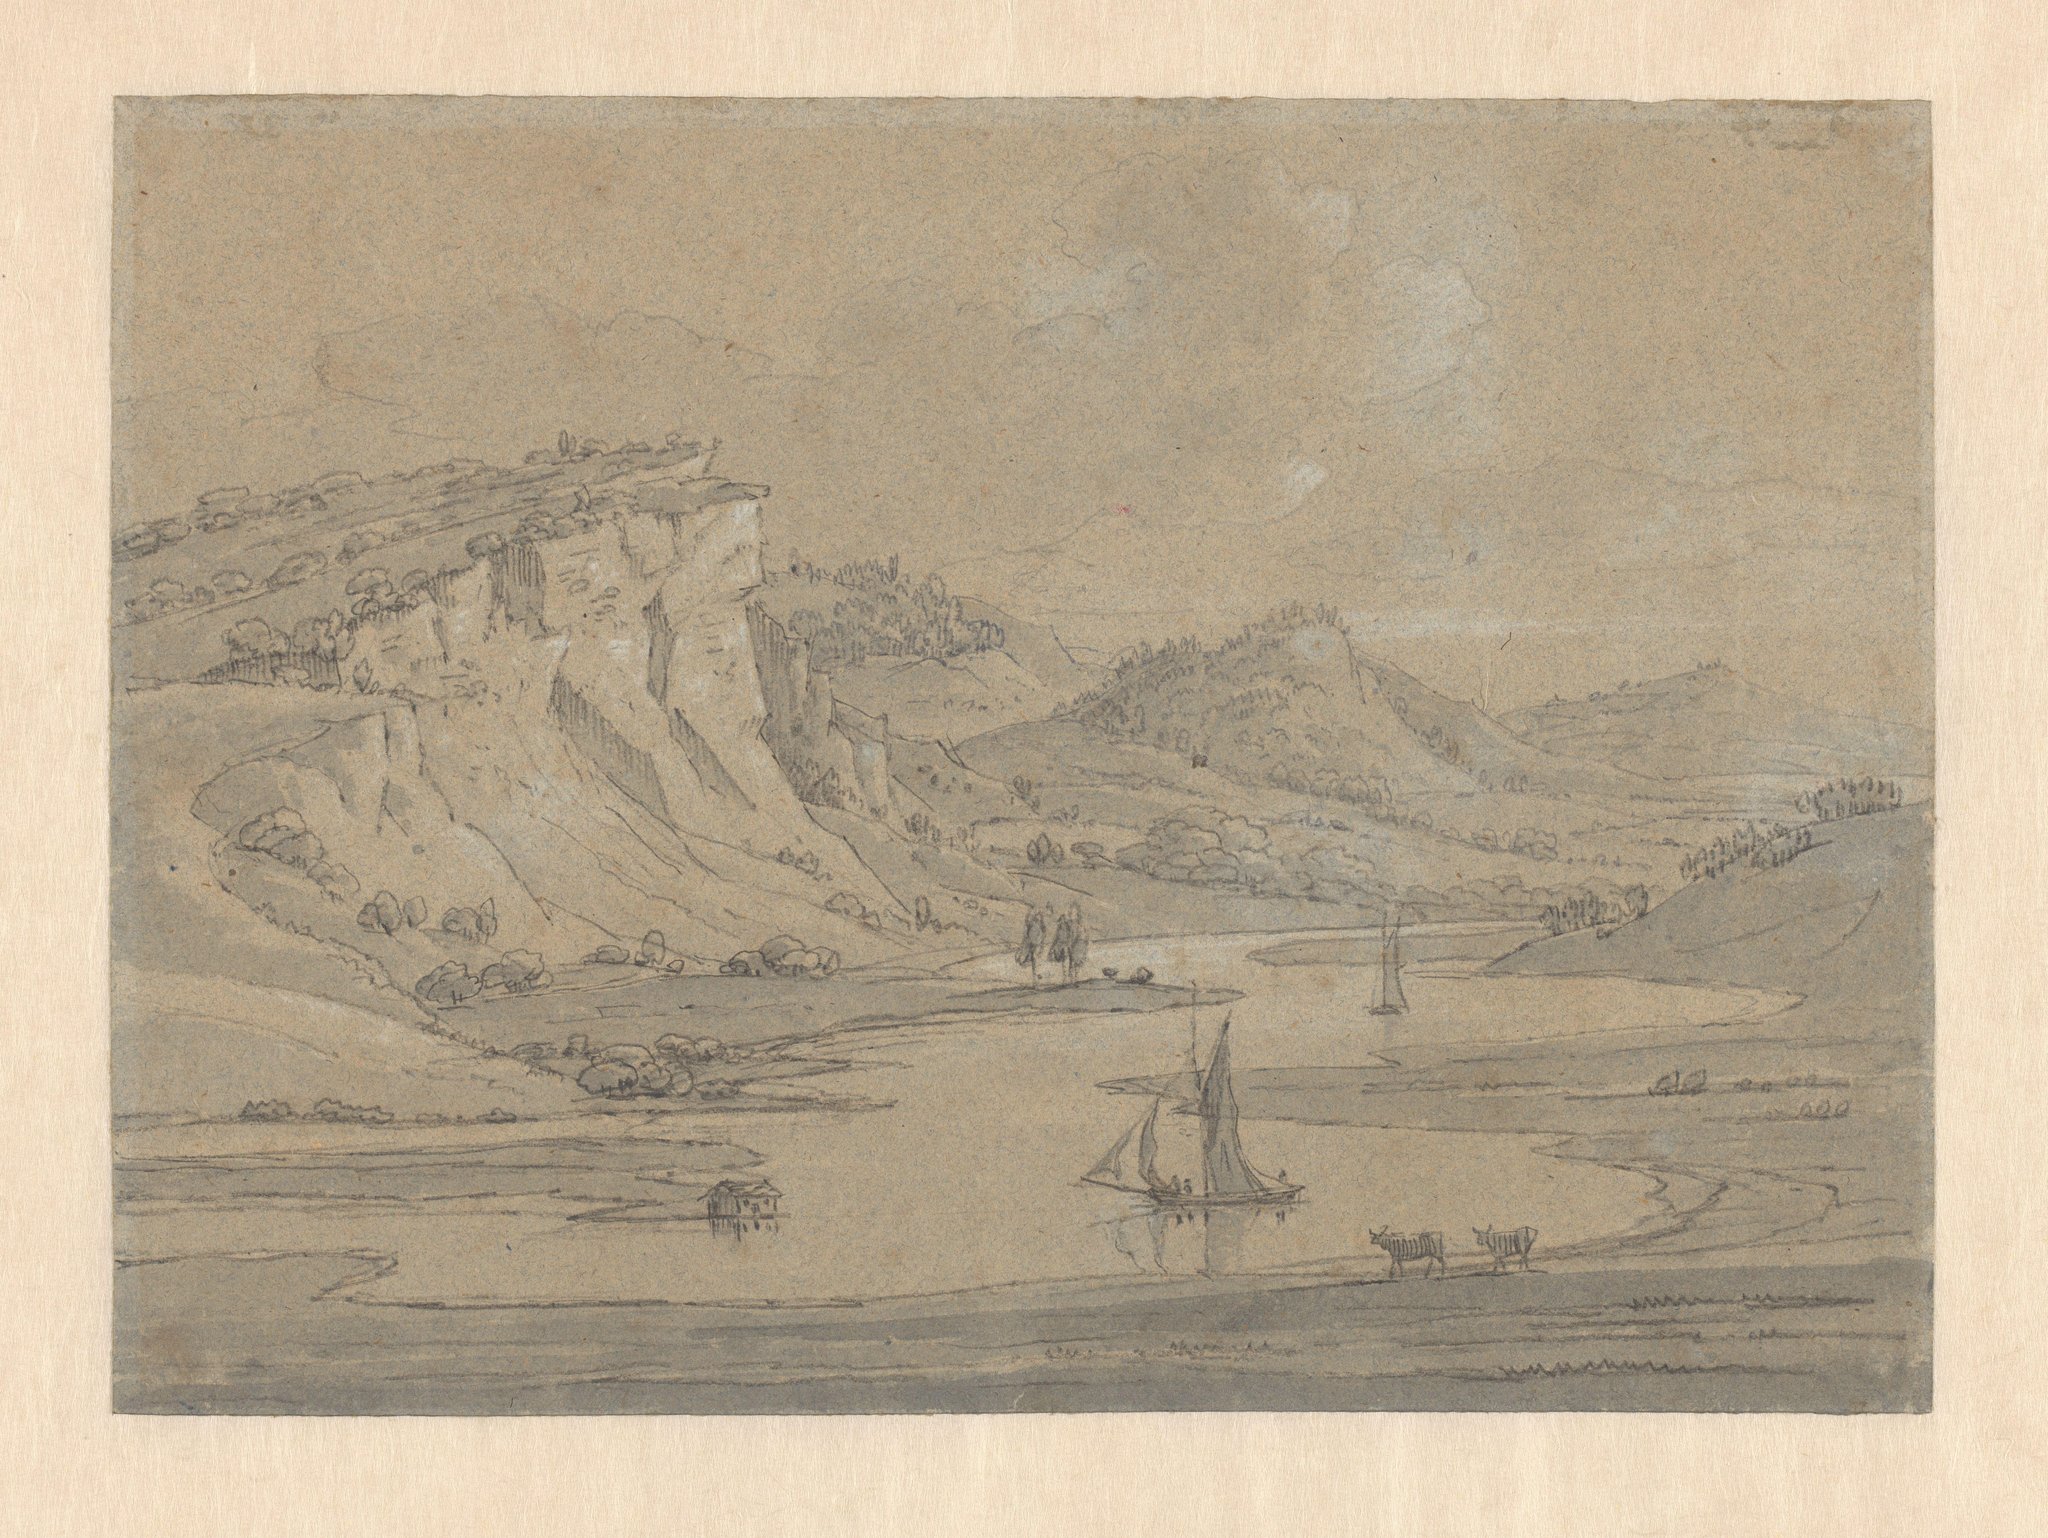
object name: drawing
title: Gezicht in het Lake District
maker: thomas sunderland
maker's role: draughtsman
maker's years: 1744-1823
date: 1754-1823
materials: graphite, ink, paper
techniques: brush, pen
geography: lake district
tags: landscapes with waters, waterscapes, seascapes (in the temperate zone)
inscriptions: inscription